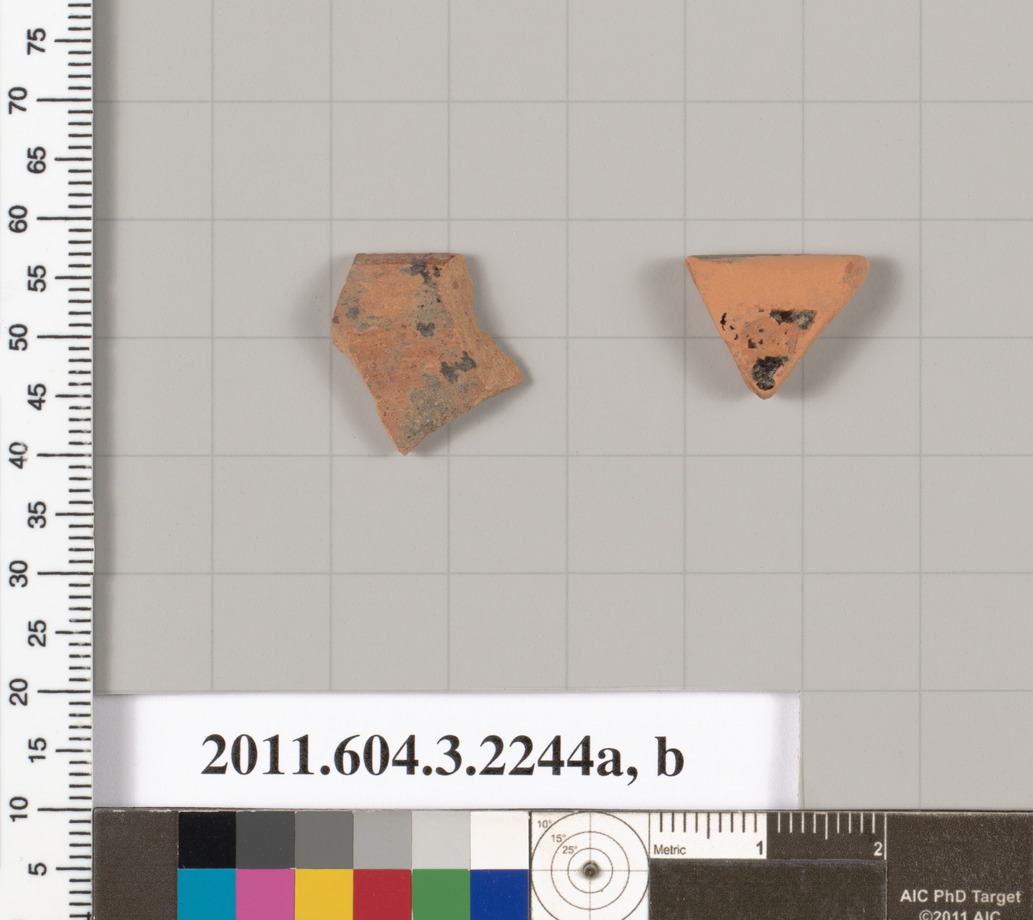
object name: kylix fragment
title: Terracotta rim fragments of kylikes (drinking cups)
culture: greek, attic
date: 600-401 BCE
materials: terracotta